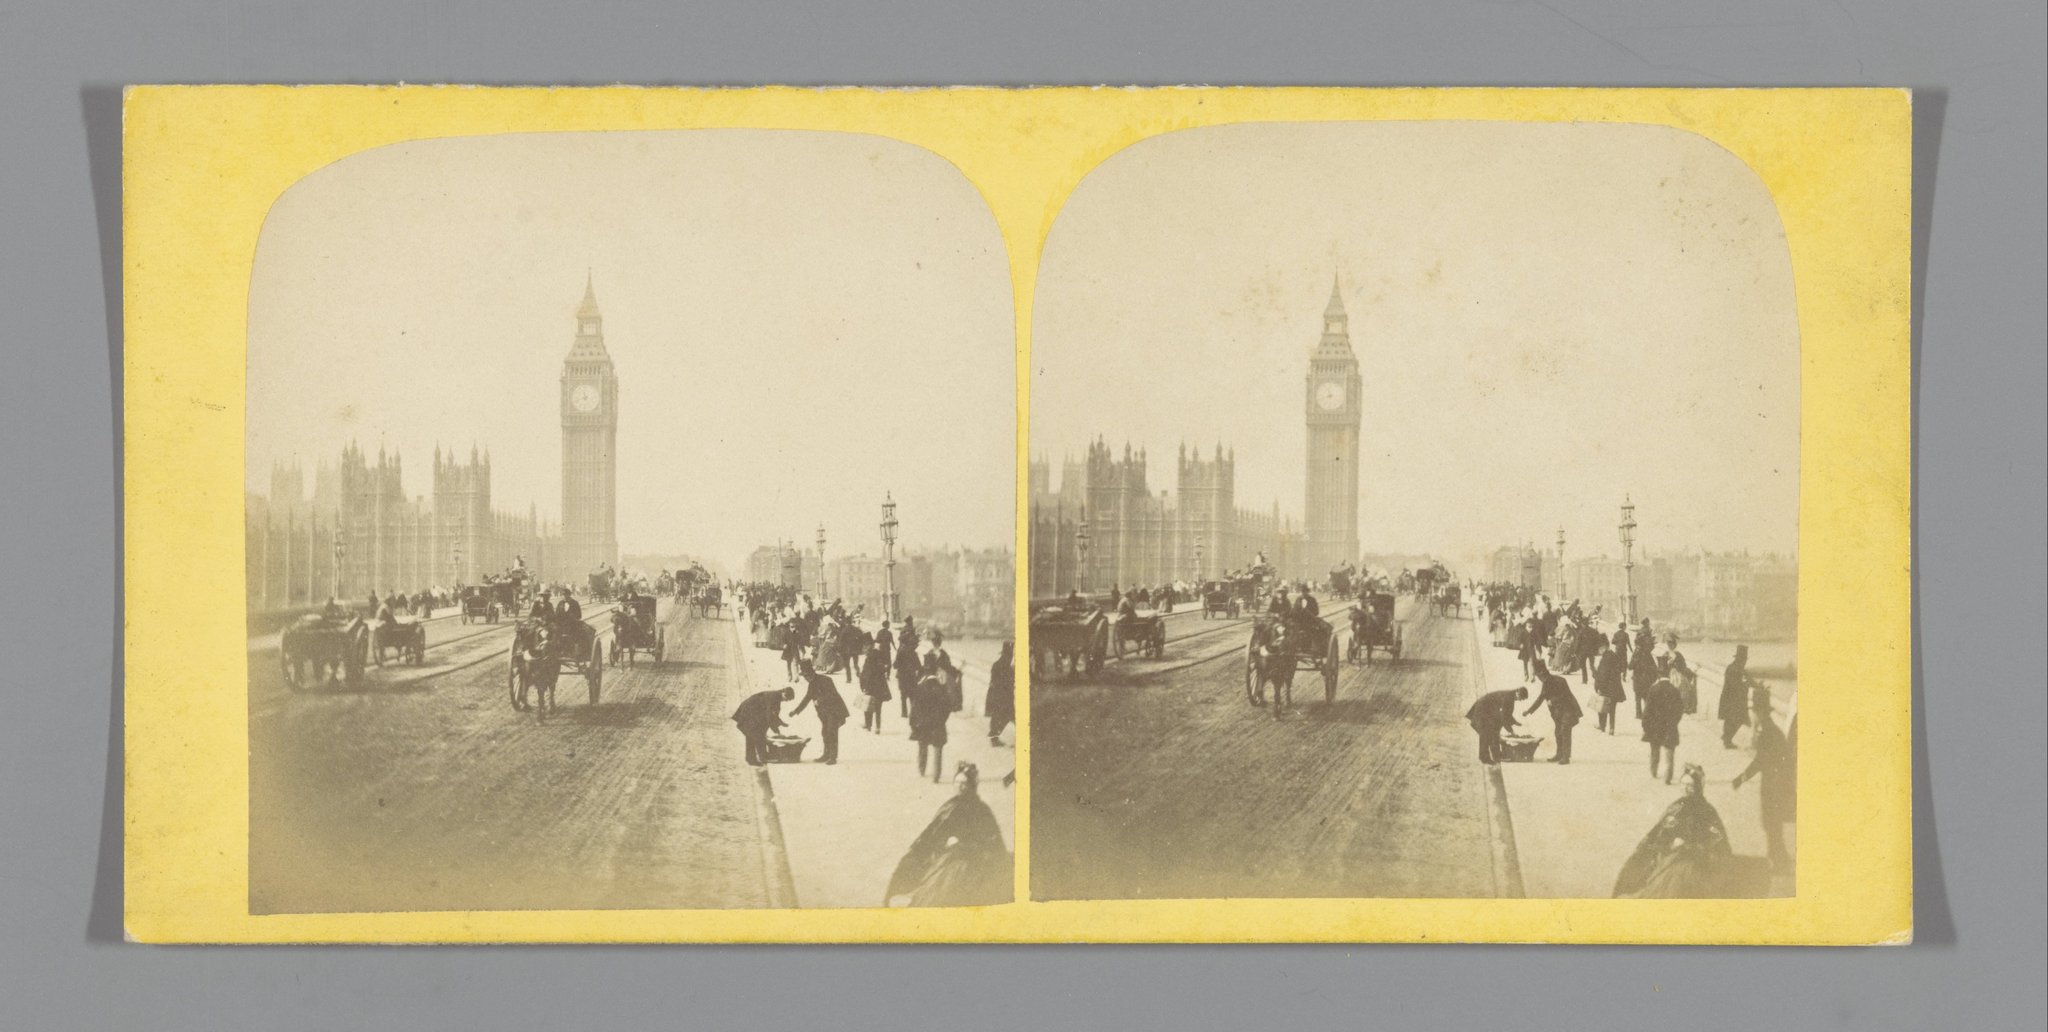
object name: stereograph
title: Instantaneous Views of London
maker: Anonymous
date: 1850-1880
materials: cardboard, photographic support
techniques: albumen print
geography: london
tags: four-wheeled, animal-drawn vehicle, e.g.: cab, carriage, coach, bridge in city across river, canal, etc., lower house, parliament, chamber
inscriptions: inscription, number: ‘No. 214.’